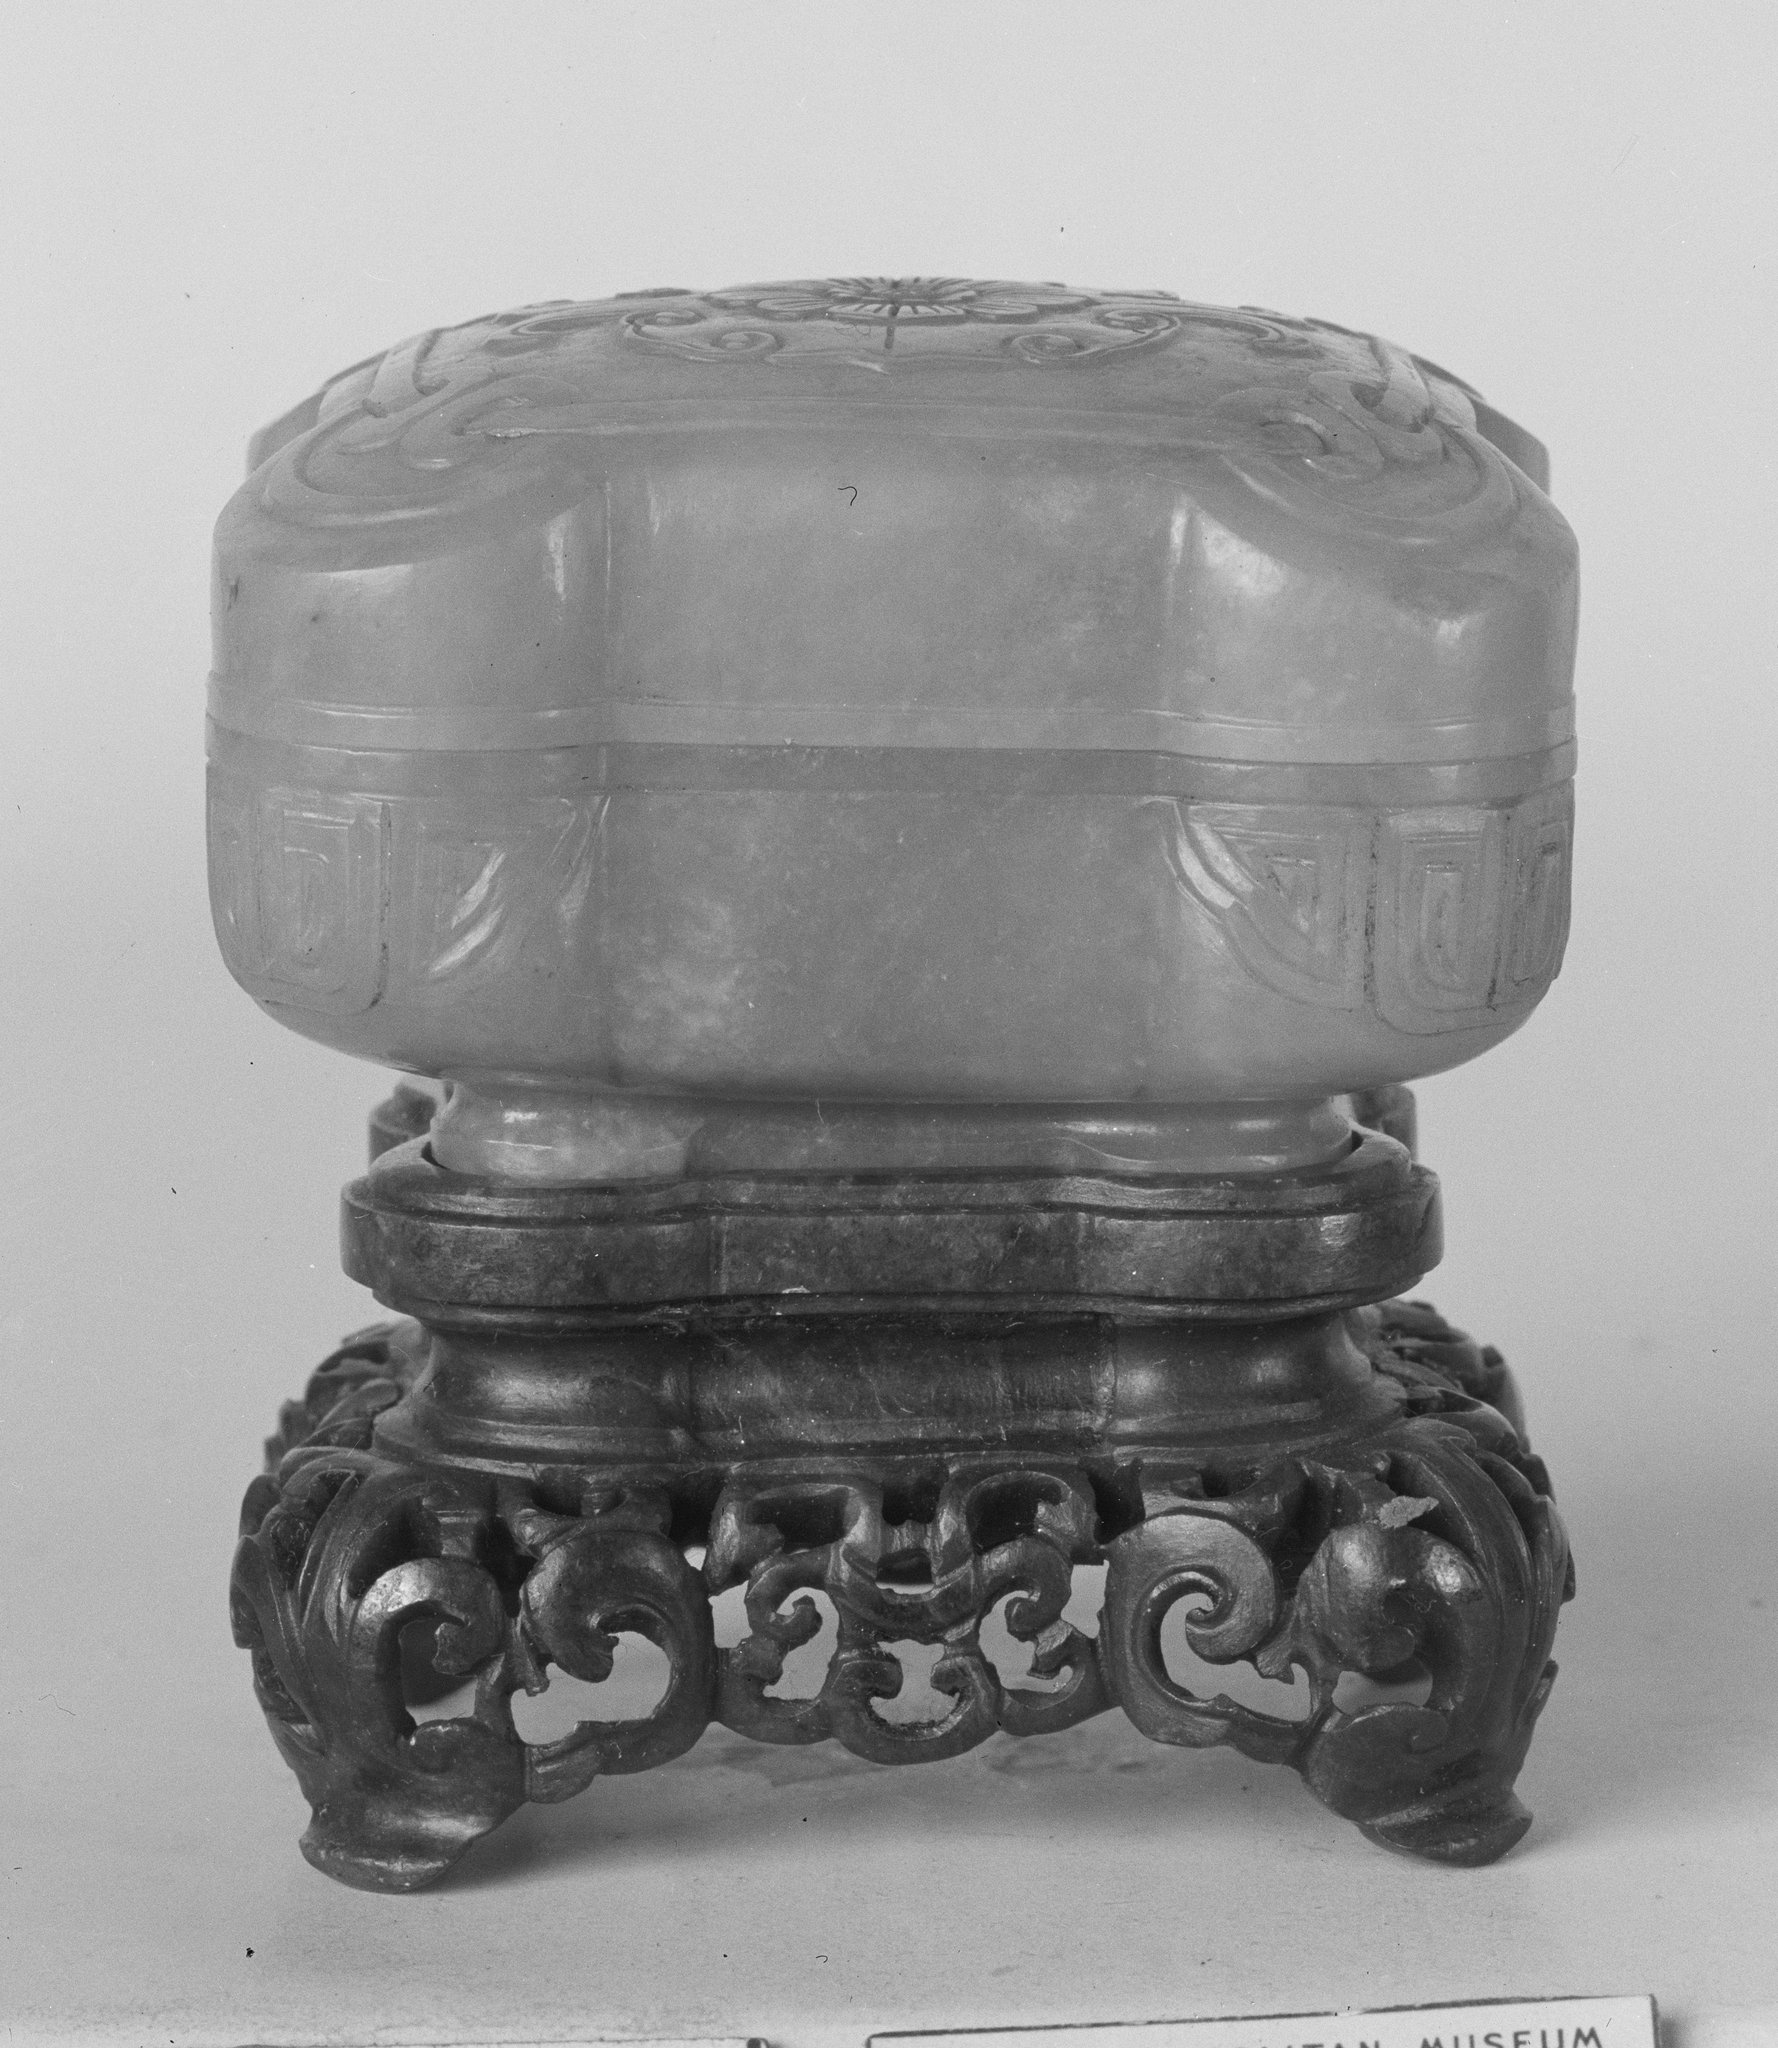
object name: incense utensil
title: Covered Incense Box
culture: chinese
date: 1767-1833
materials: jade